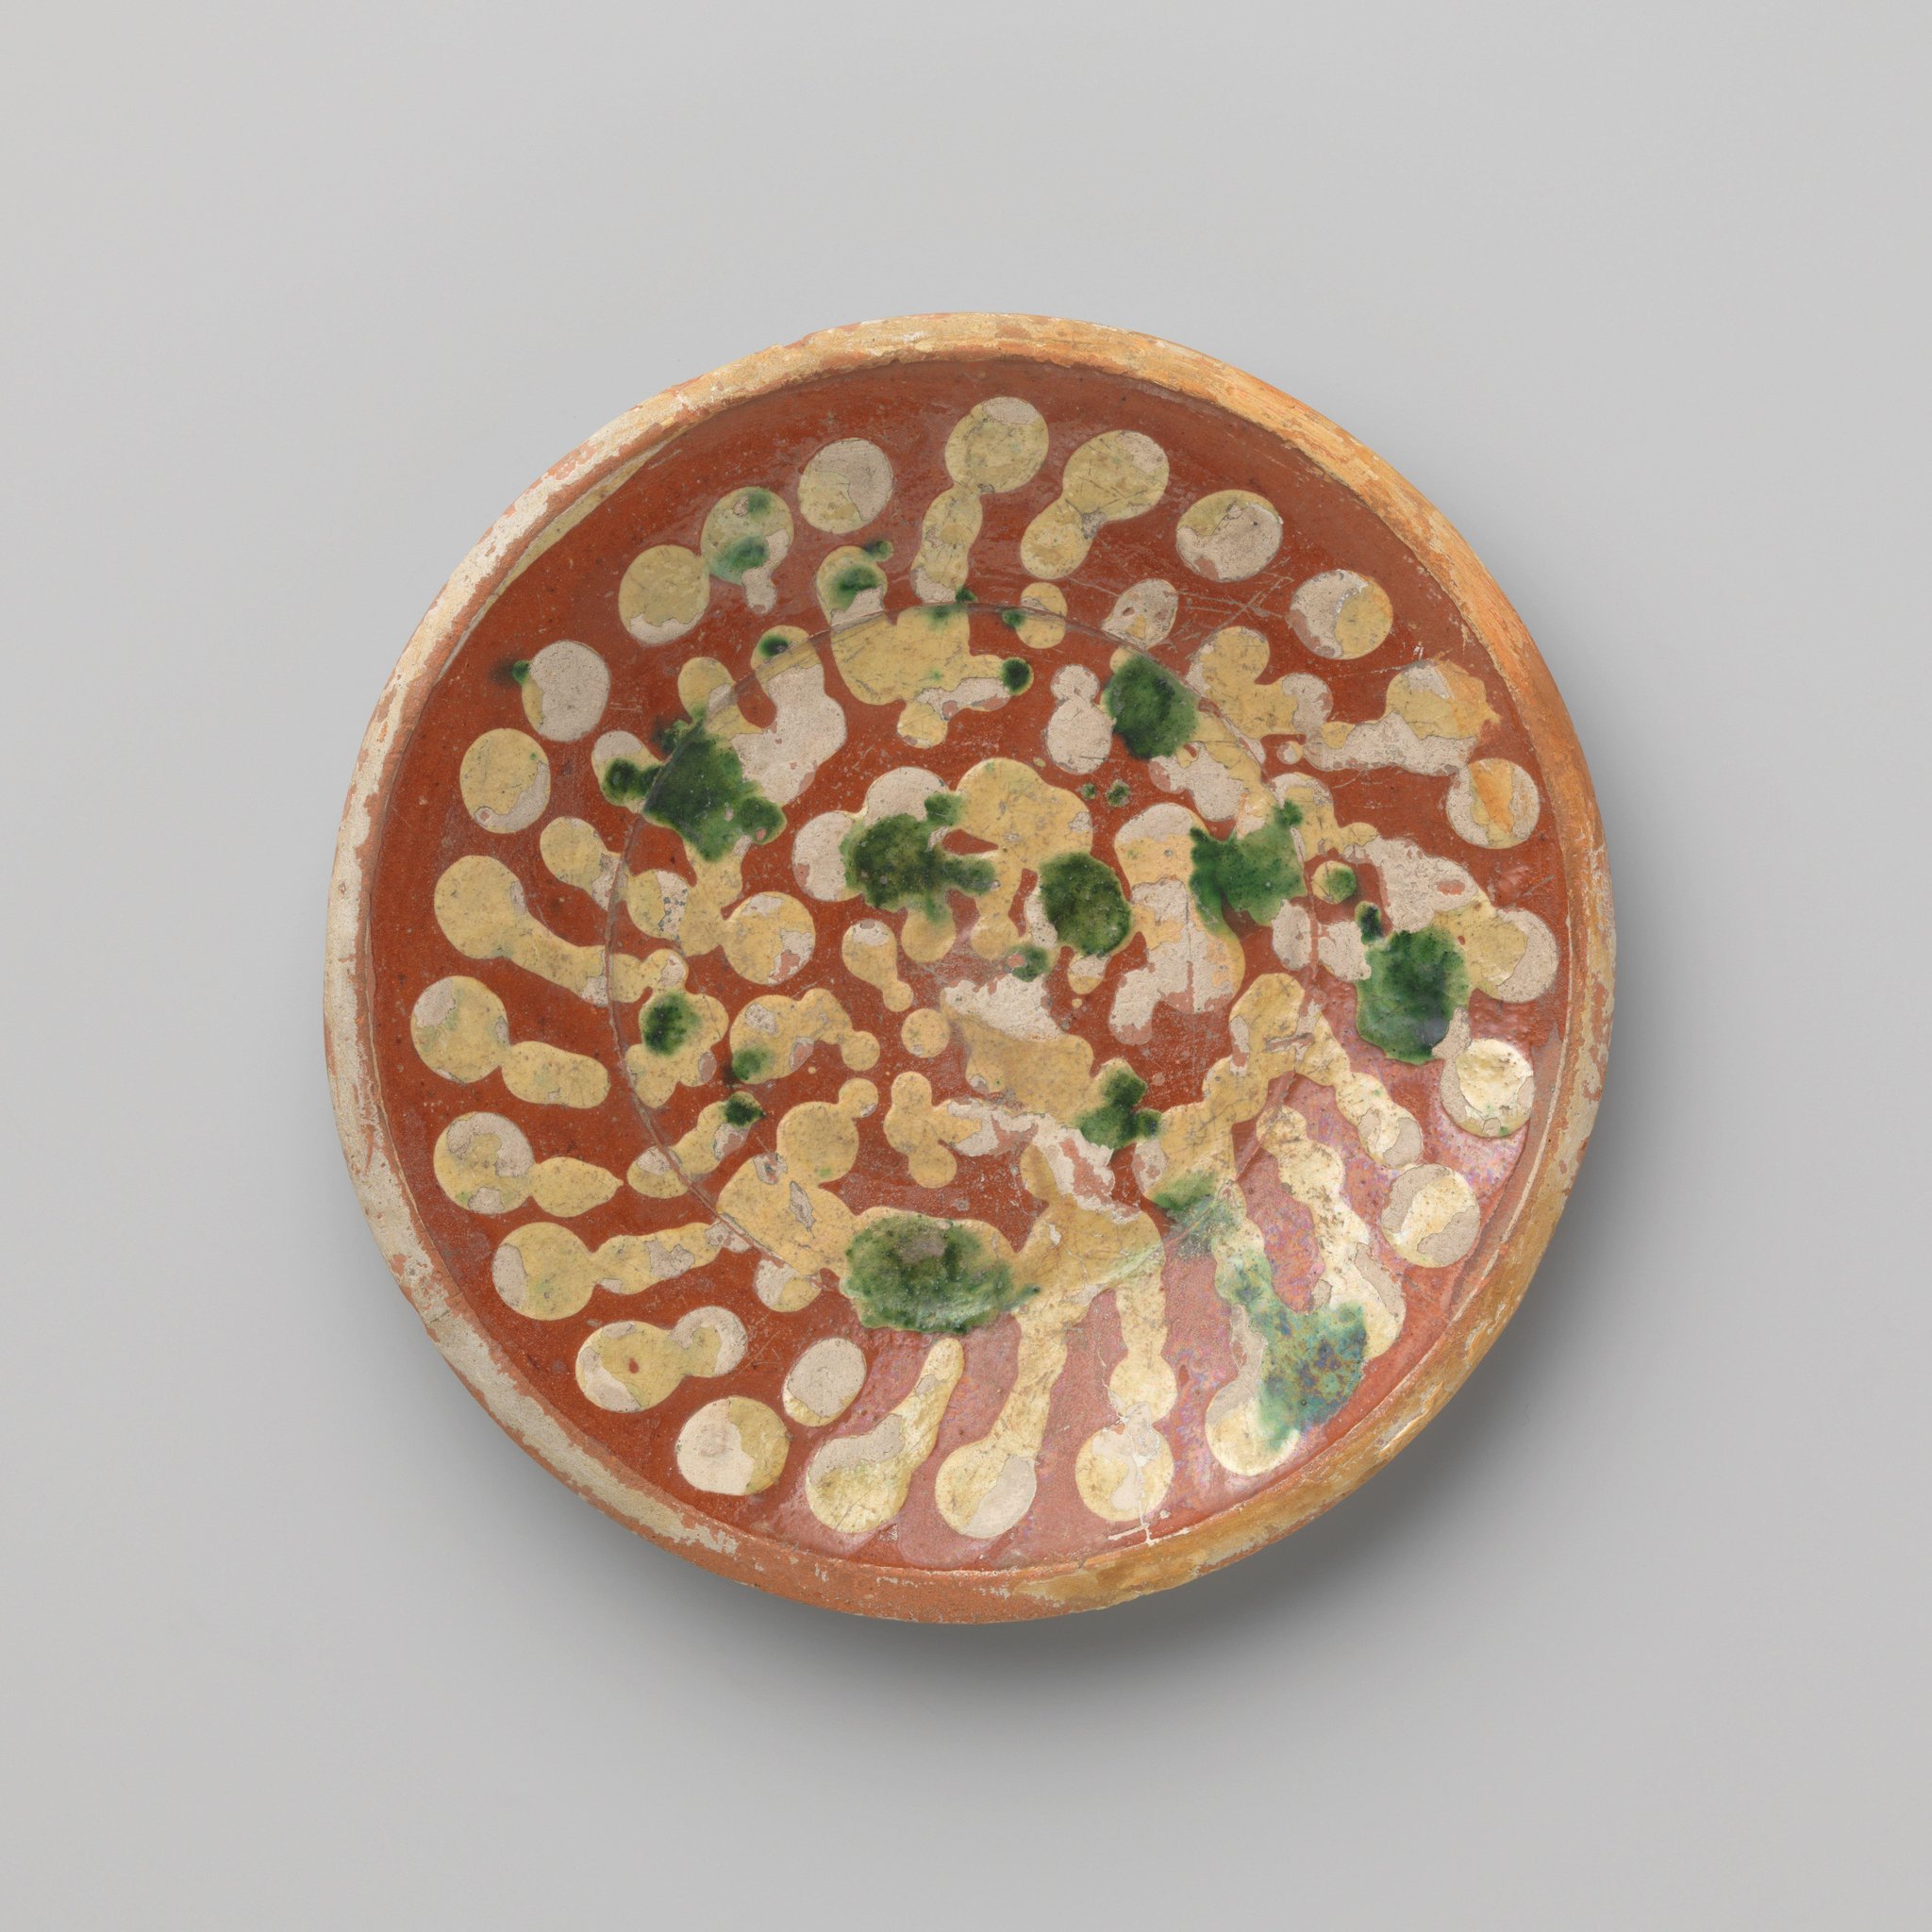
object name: plate dish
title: Bord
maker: Anonymous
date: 1625-1700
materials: earthenware, glaze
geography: netherlands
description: Rond bord van loodglazuuraardewerk. Het bord is grof gedecoreerd met onregelmatig aangebrachte witte punten en strepen en op enkele plaatsen groen email.